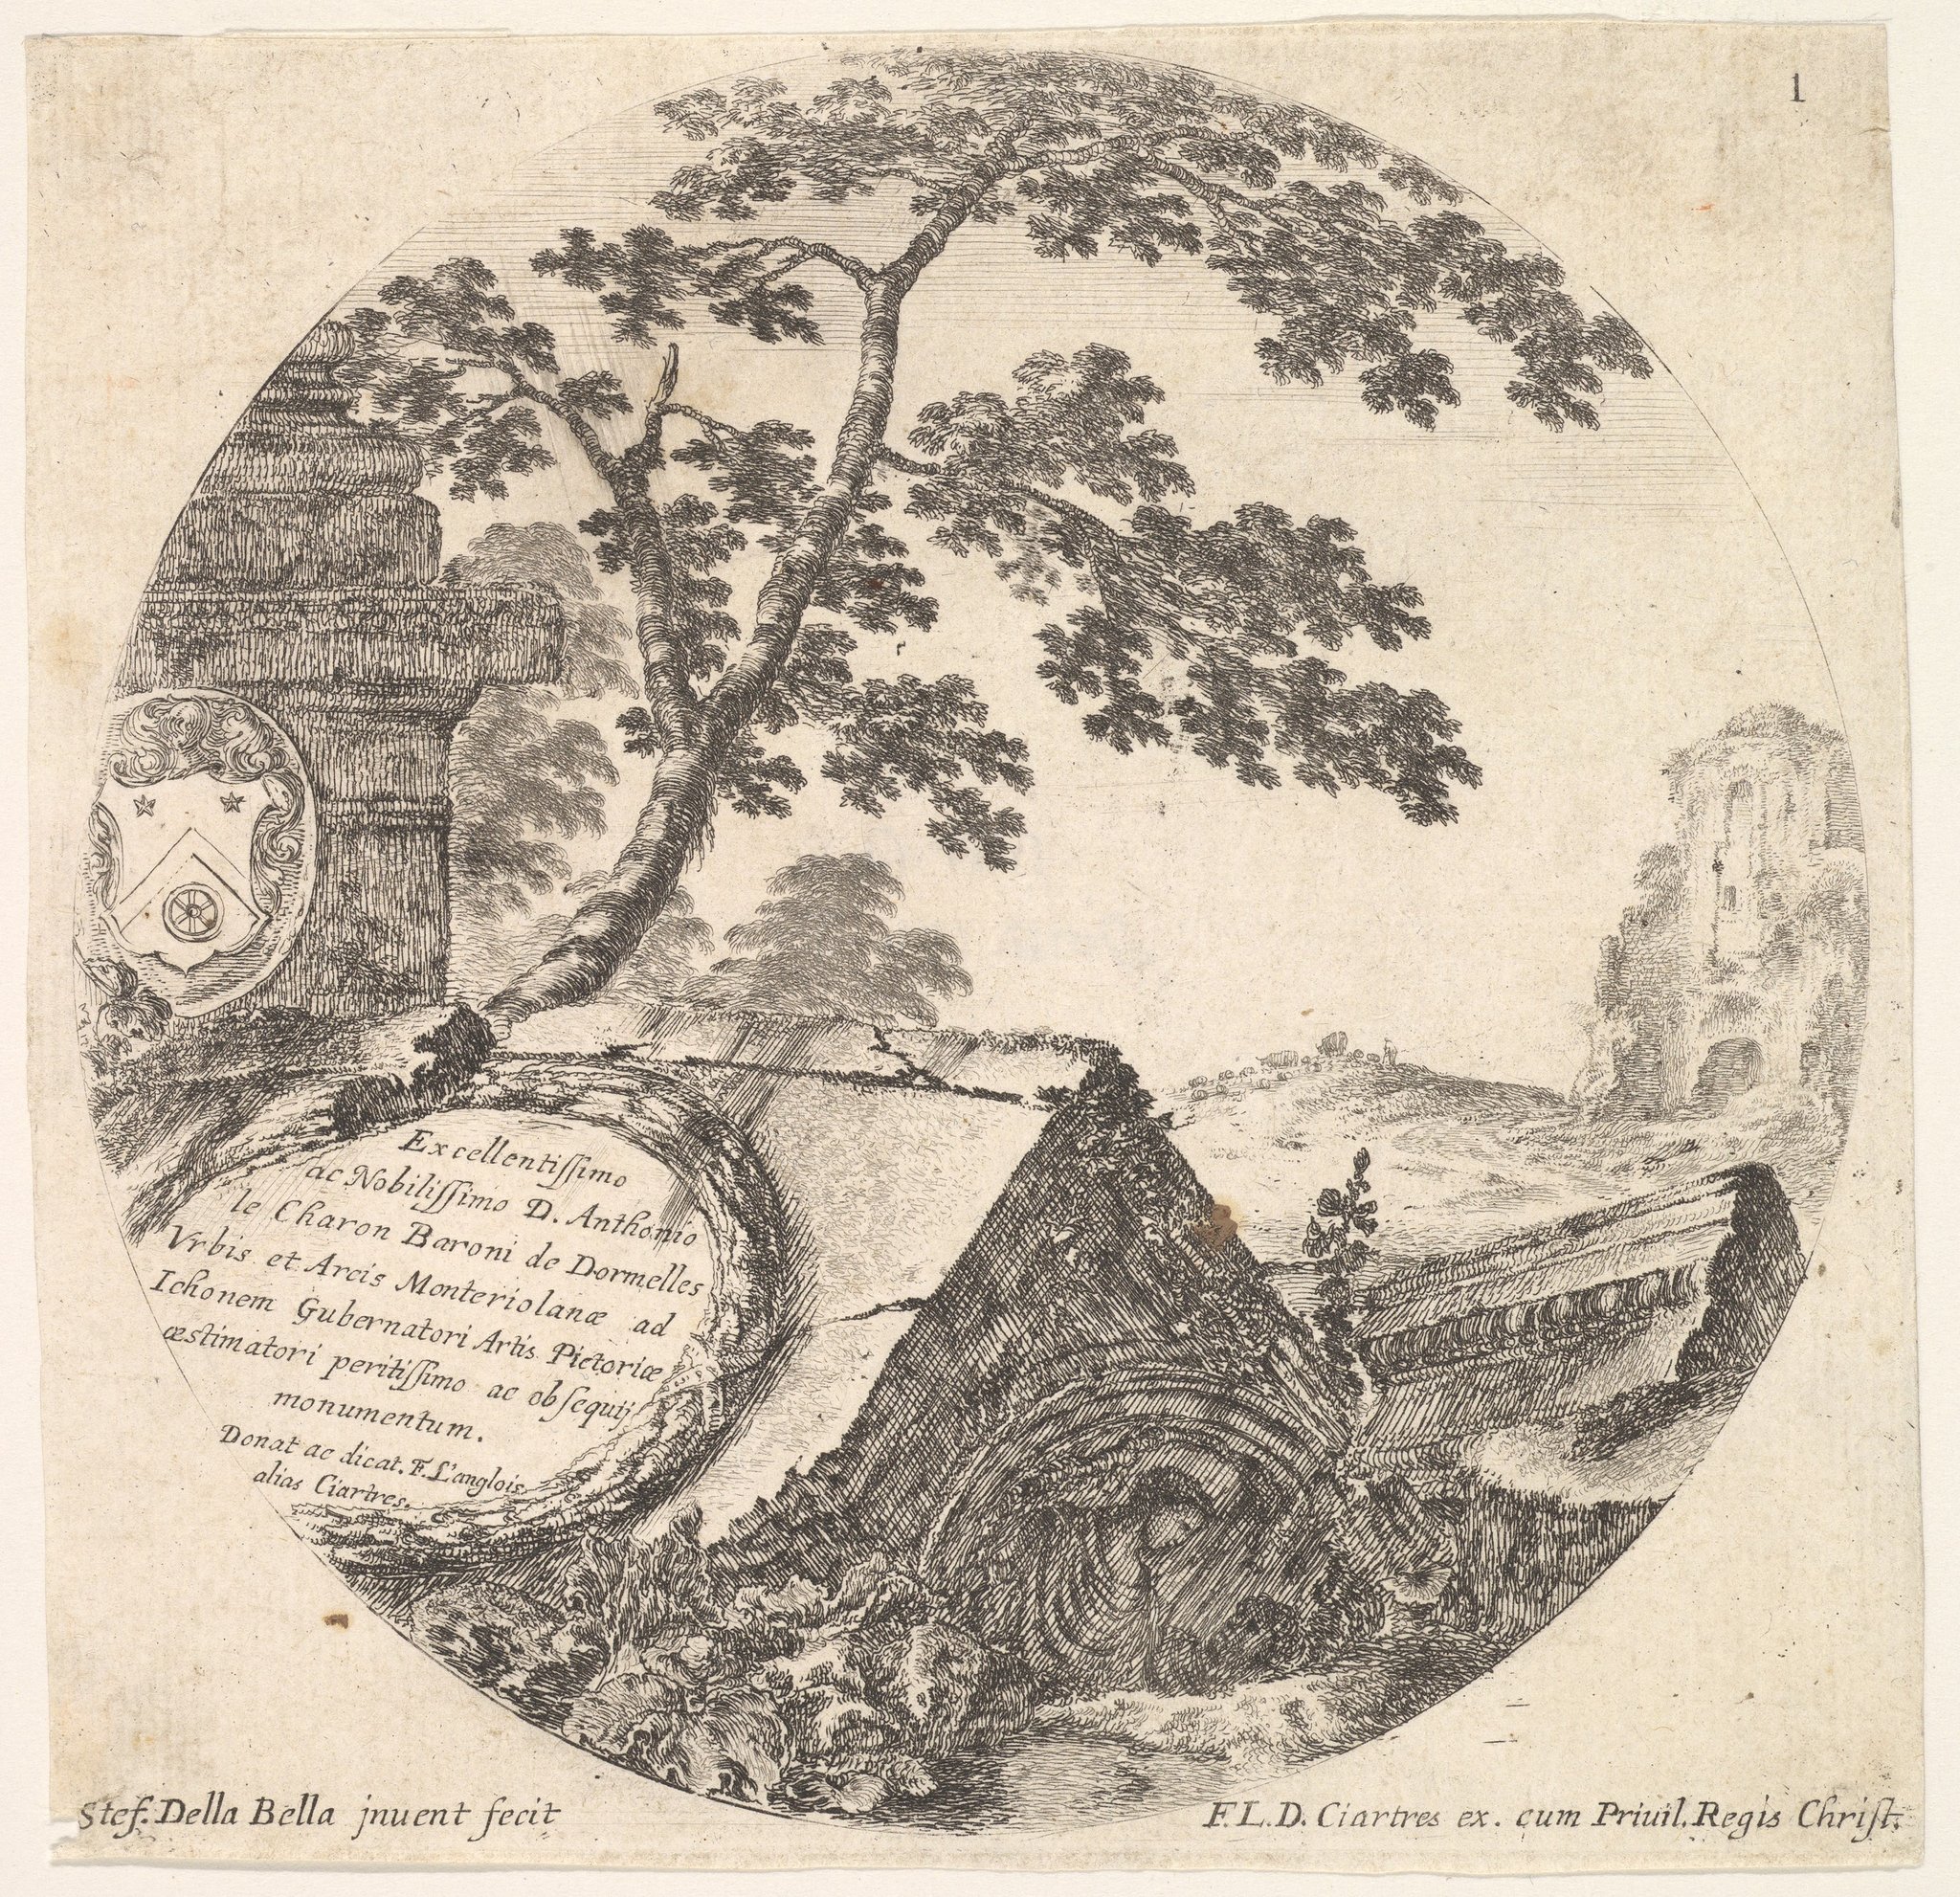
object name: print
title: Plate 1: various fragments of ancient monuments, from "Roman landscapes and ruins" (Paysages et ruines de Rome)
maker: stefano della bella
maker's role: artist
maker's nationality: italian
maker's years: 1610-1664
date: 1643-1648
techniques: etching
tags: ruins